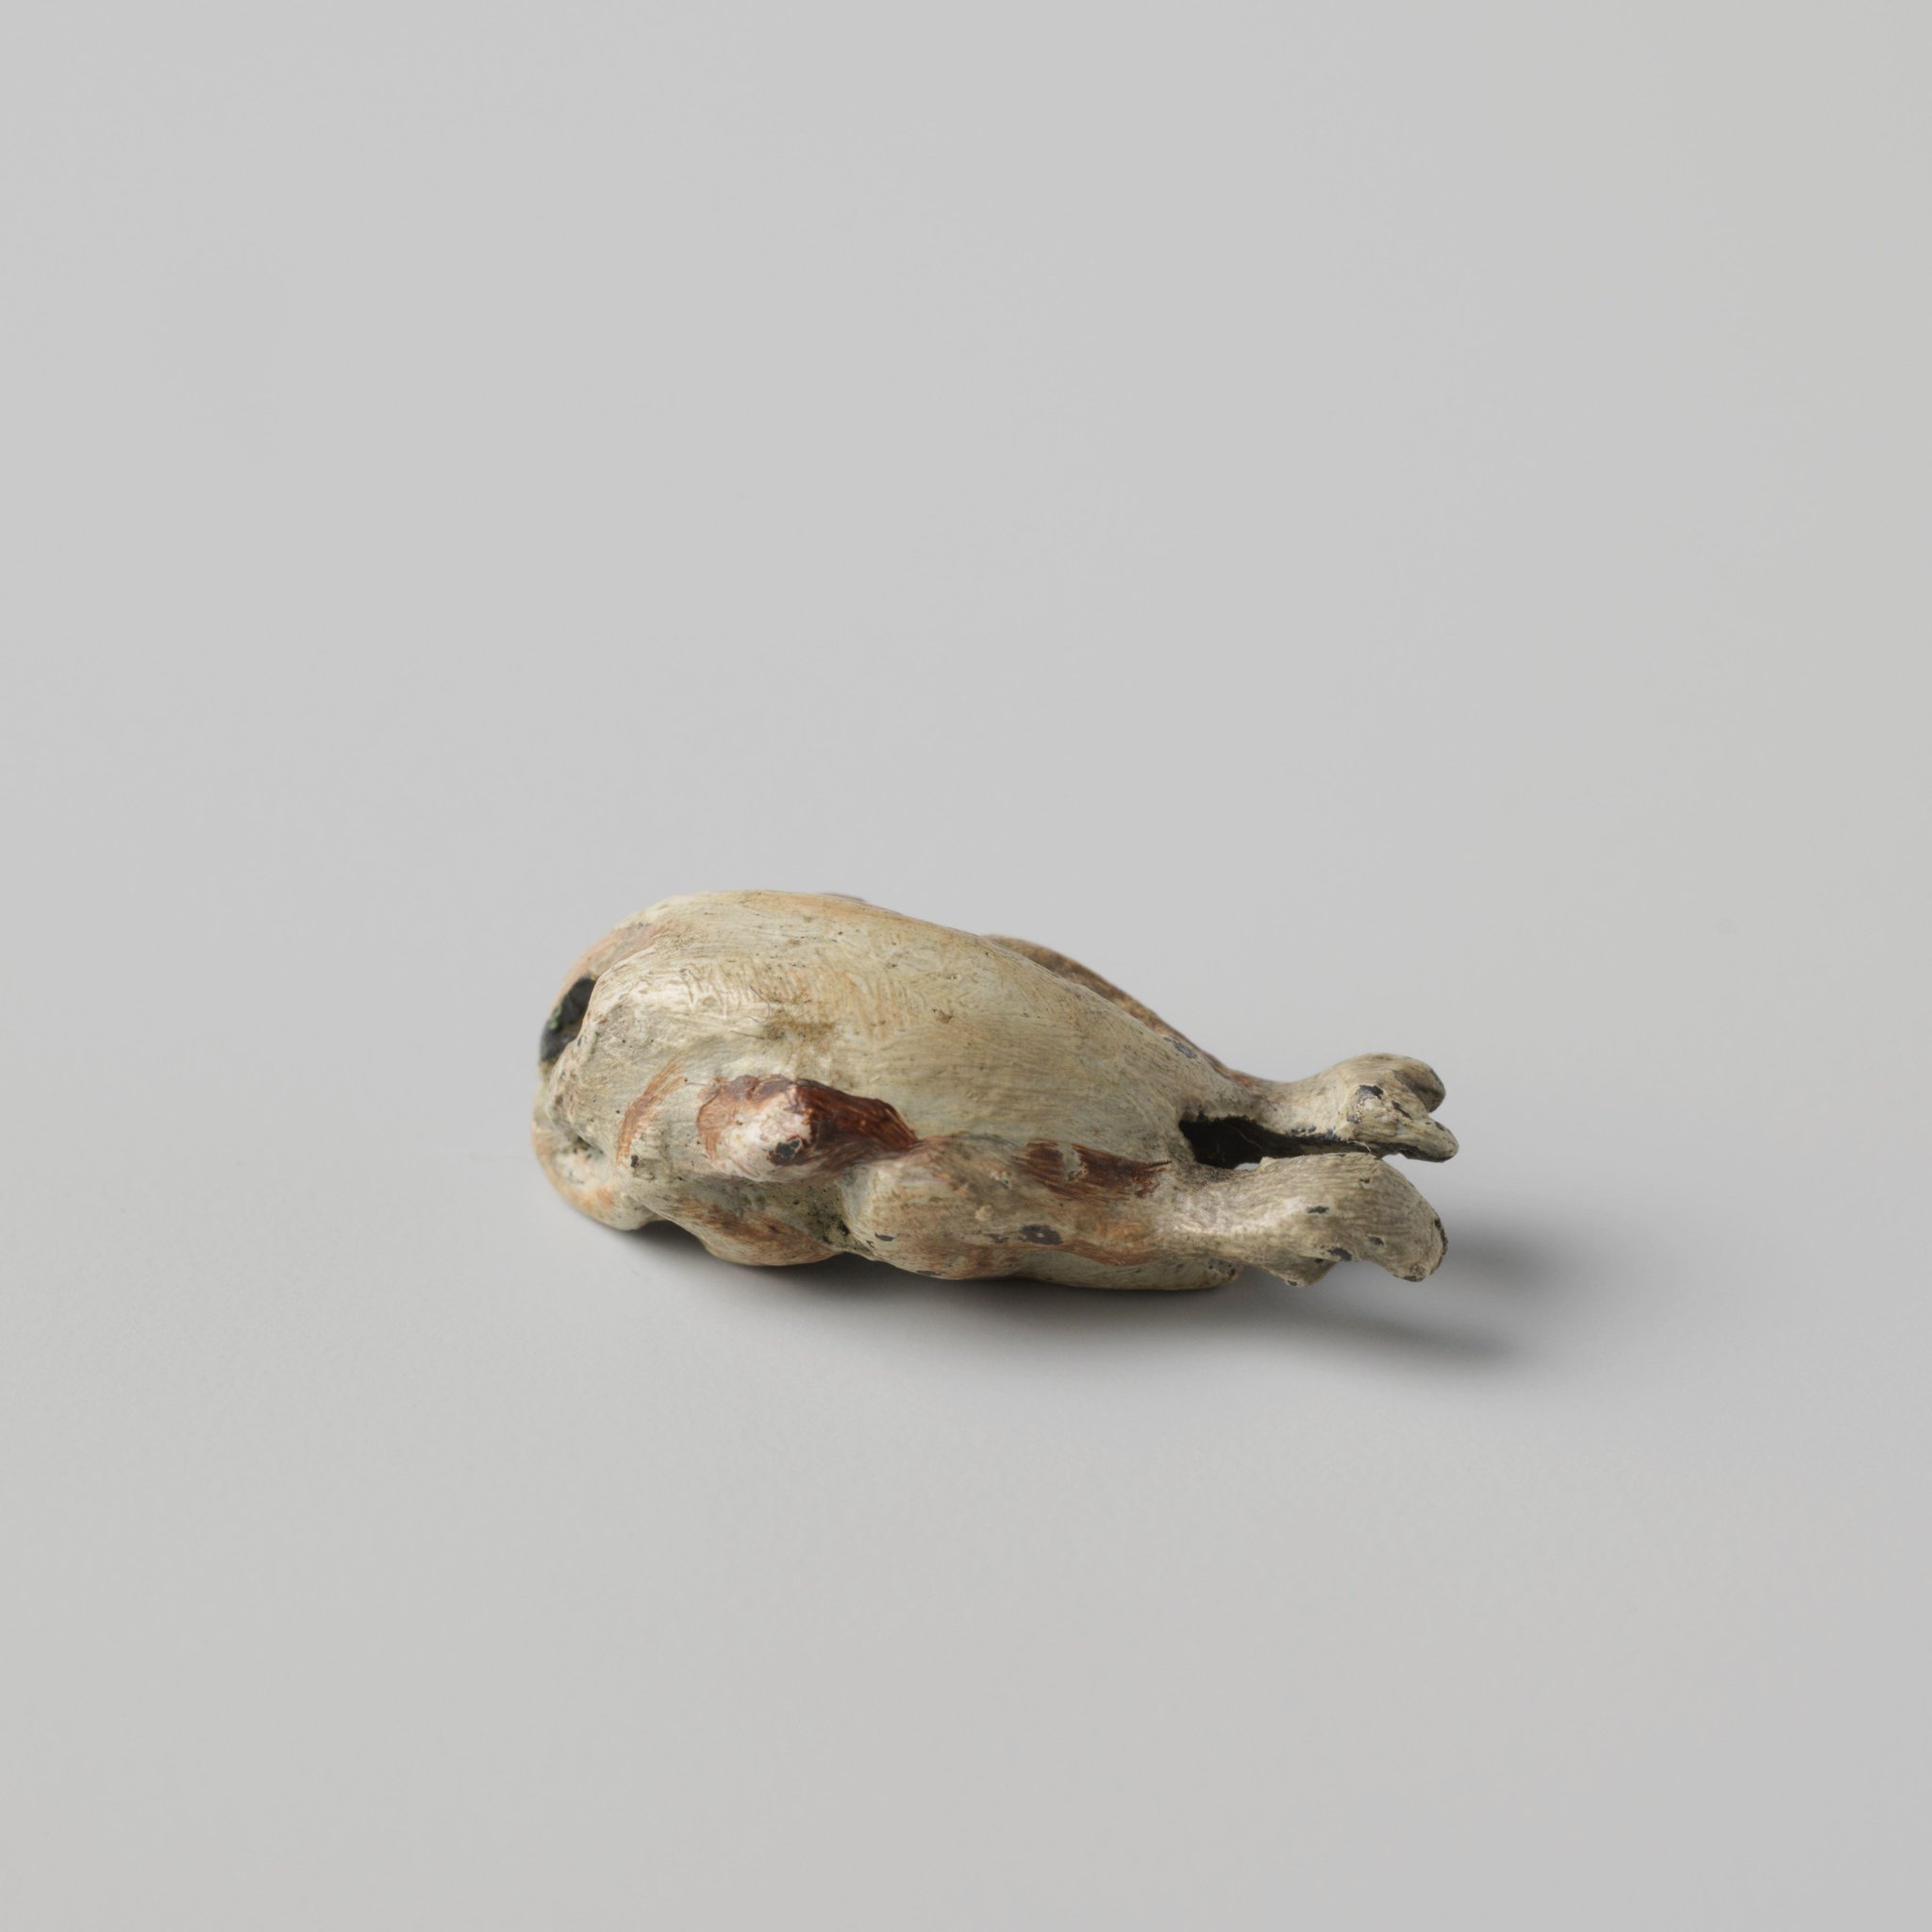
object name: miniature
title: Gebraden kip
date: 1700-1799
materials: tin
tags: fowl (cock, hen, chicken, etc.)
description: Gebraden kip van hol metaal, grijs met roodbruin geschilderd; romp met vleugels opzij en poten naar achteren gestoken.